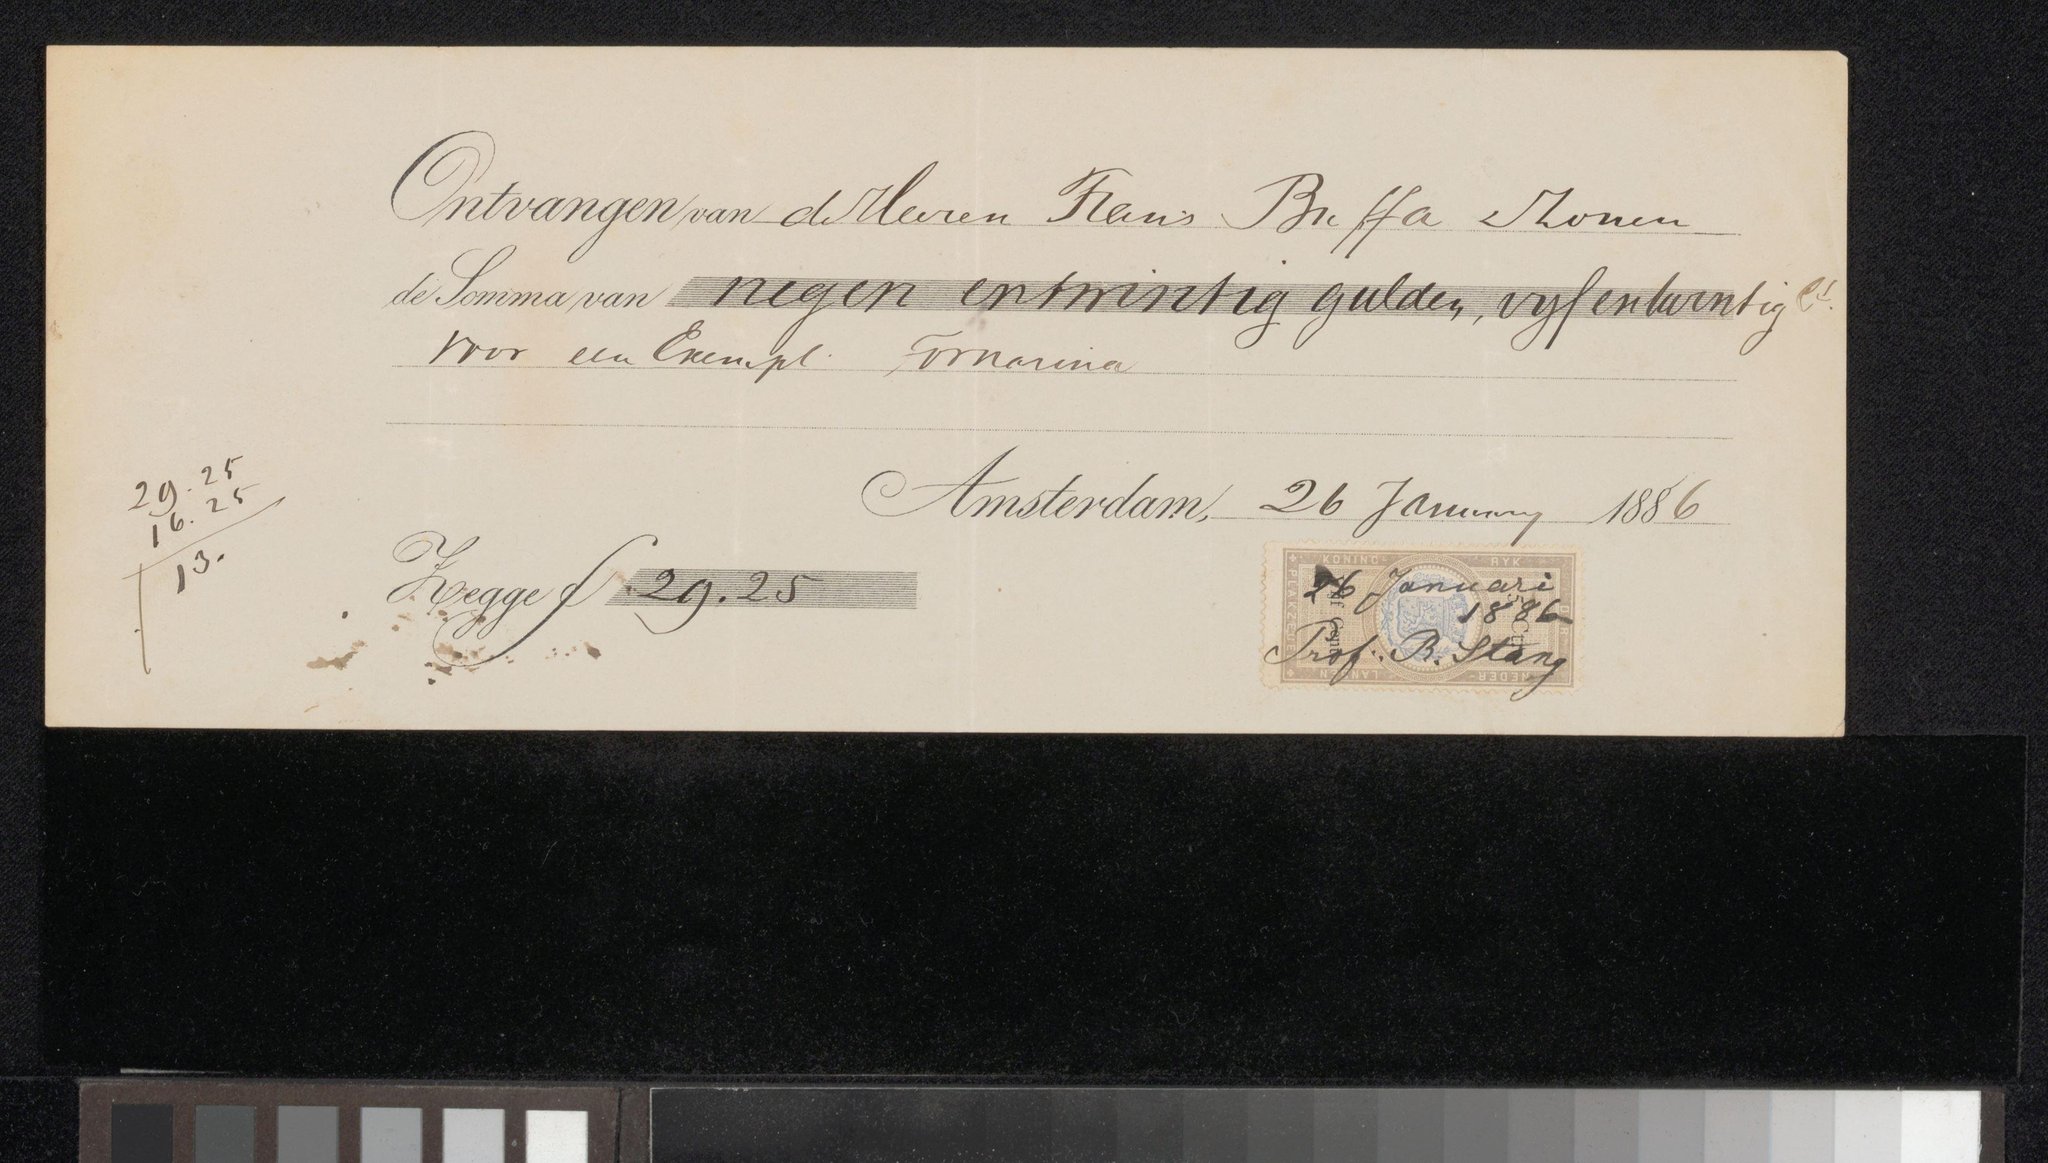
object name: ontvangstbewijs, kwitantie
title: Kwitantie voor Rudolf Stang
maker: rudolf stang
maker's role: draughtsman, painter, print maker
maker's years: 1831-1927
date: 1886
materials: ink, paper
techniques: pen, printing, writing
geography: amsterdam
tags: the graphic arts, money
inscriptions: collector's mark: Lugt 2233